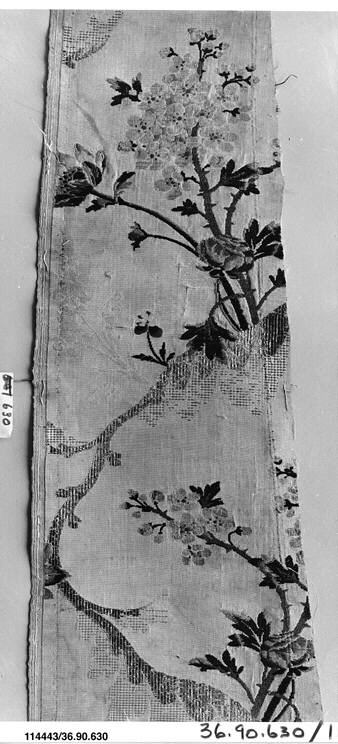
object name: piece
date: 1750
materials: metal thread, silk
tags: flowers